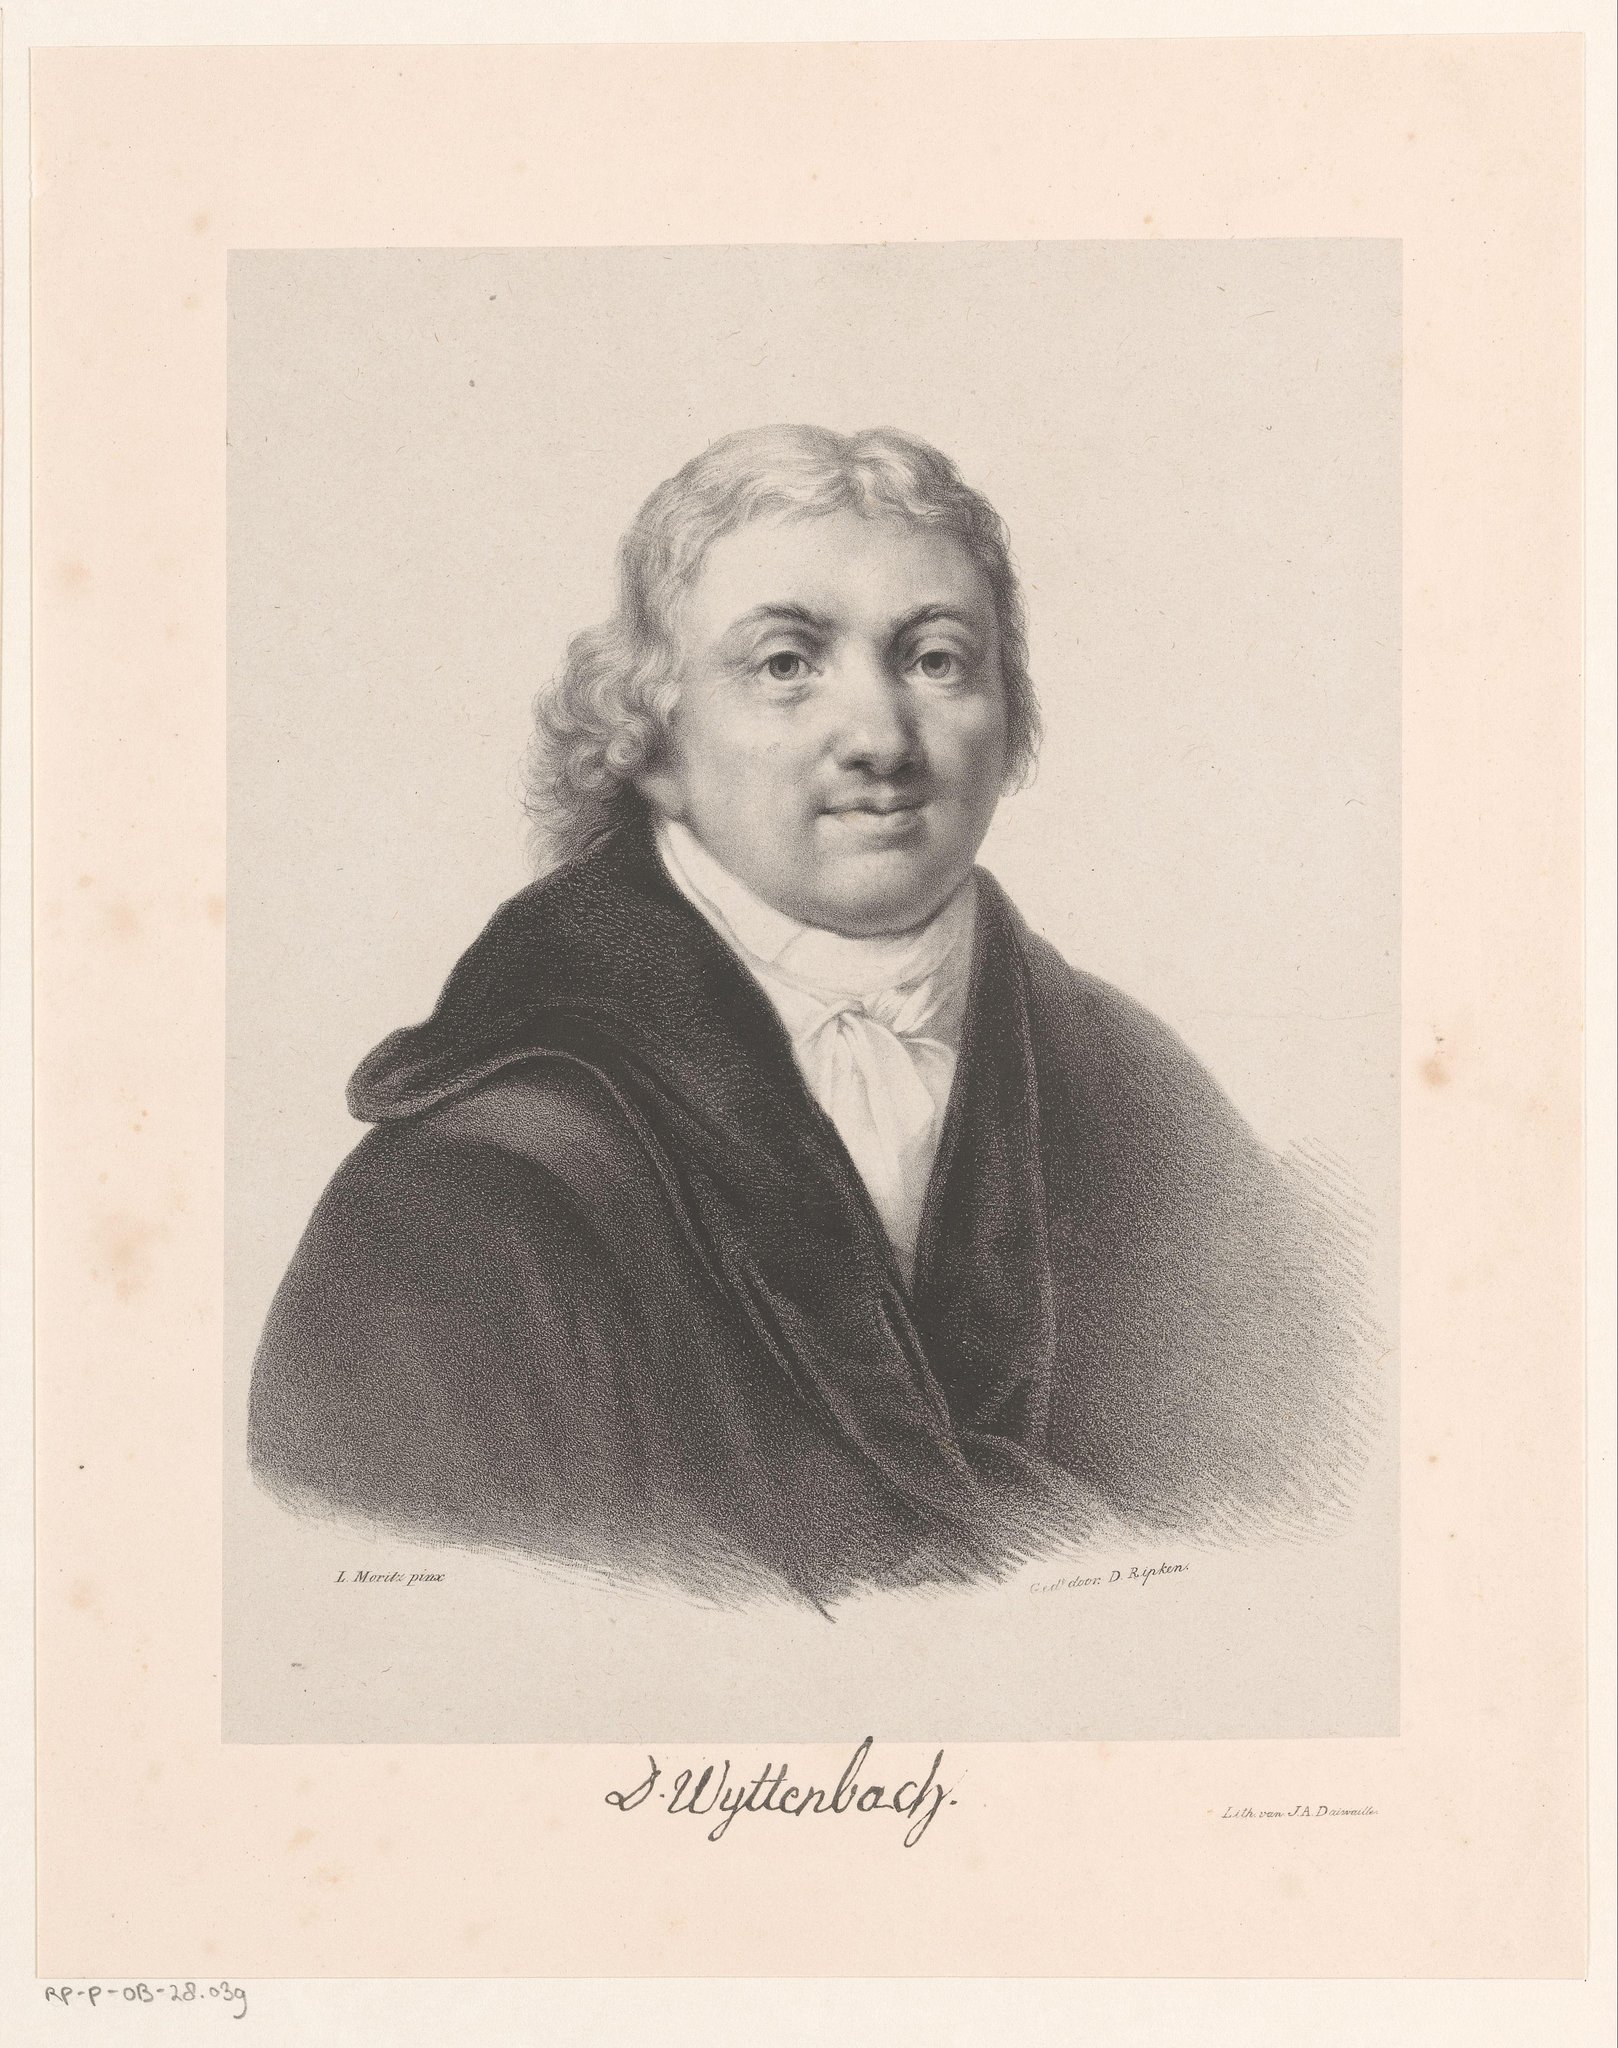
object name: print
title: Portret van Daniël Wyttenbach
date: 1809-1850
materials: paper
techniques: lithograph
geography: netherlands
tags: historical persons (+ (full) bust portrait)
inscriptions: collector's mark: Lugt 2228, inscription: ‘D. Wyttenbach’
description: De geportretteerde draagt een zwarte mantel.